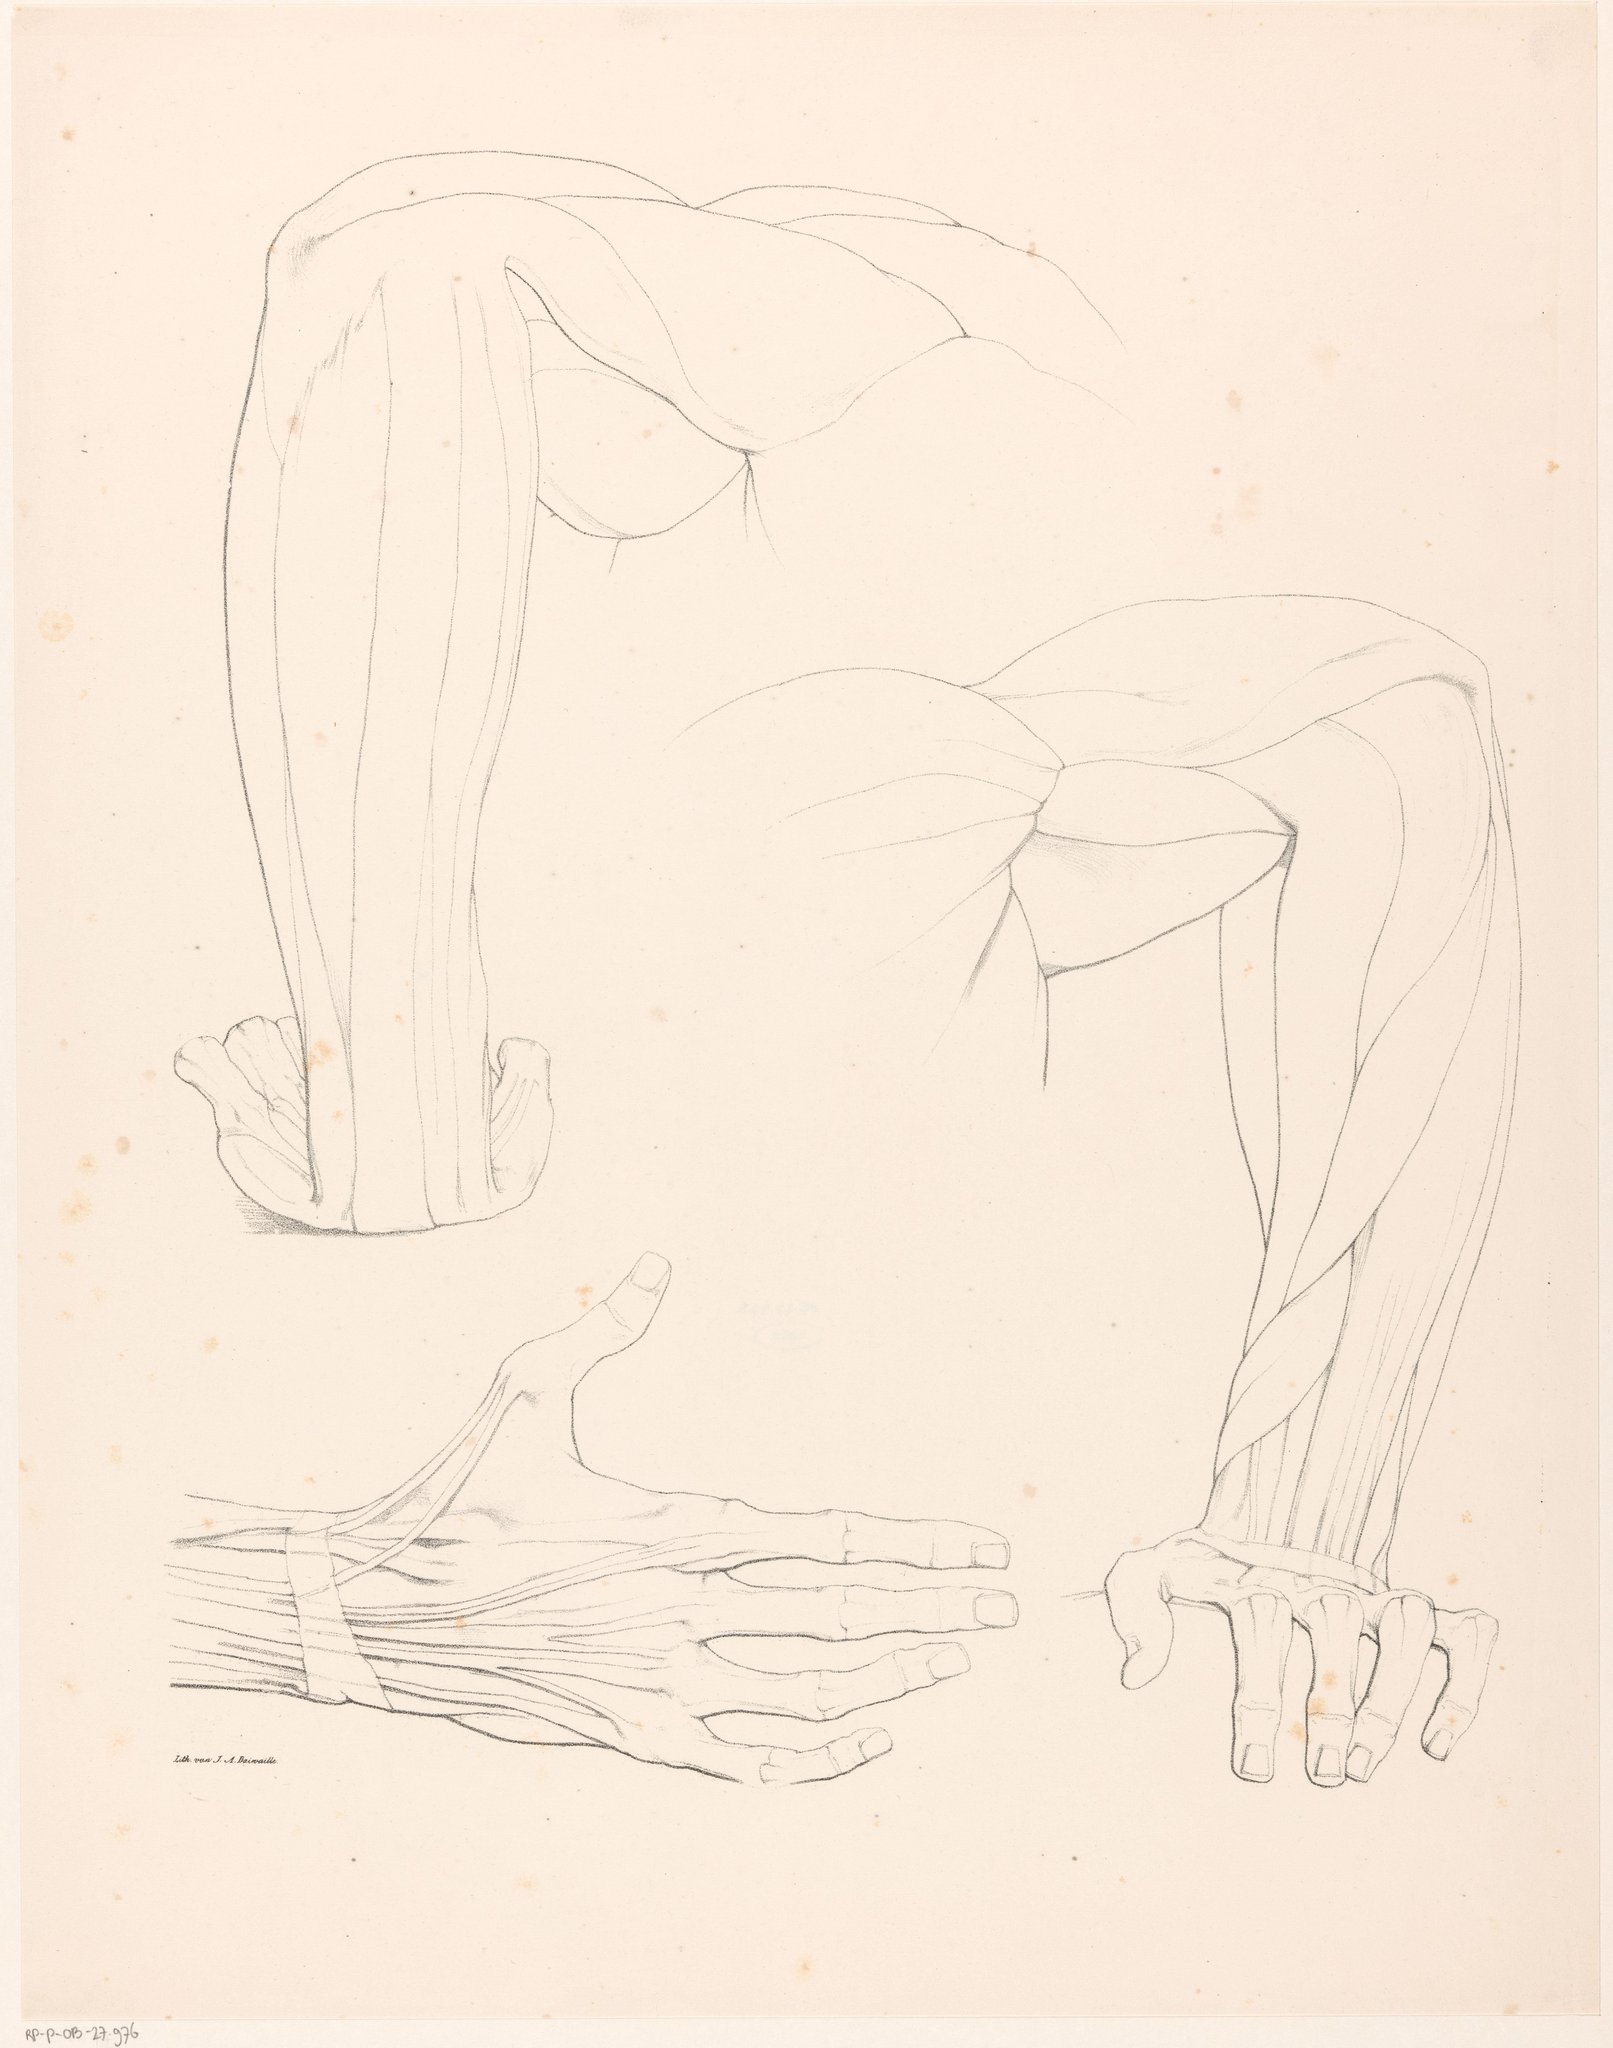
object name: print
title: Armen en hand met spierbundels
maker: jean augustin daiwaille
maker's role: draughtsman, print maker, printer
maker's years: 1786-1850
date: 1820-1833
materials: paper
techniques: lithograph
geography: amsterdam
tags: arms, hand, muscles, anatomical model of the muscles, muscle-man, 'écorché'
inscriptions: collector's mark: Lugt 2228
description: De armen zijn gebogen en de handen steunen op een ondergrond. De rug van de losse rechterhand is afgebeeld, de hand is uitgestrekt.